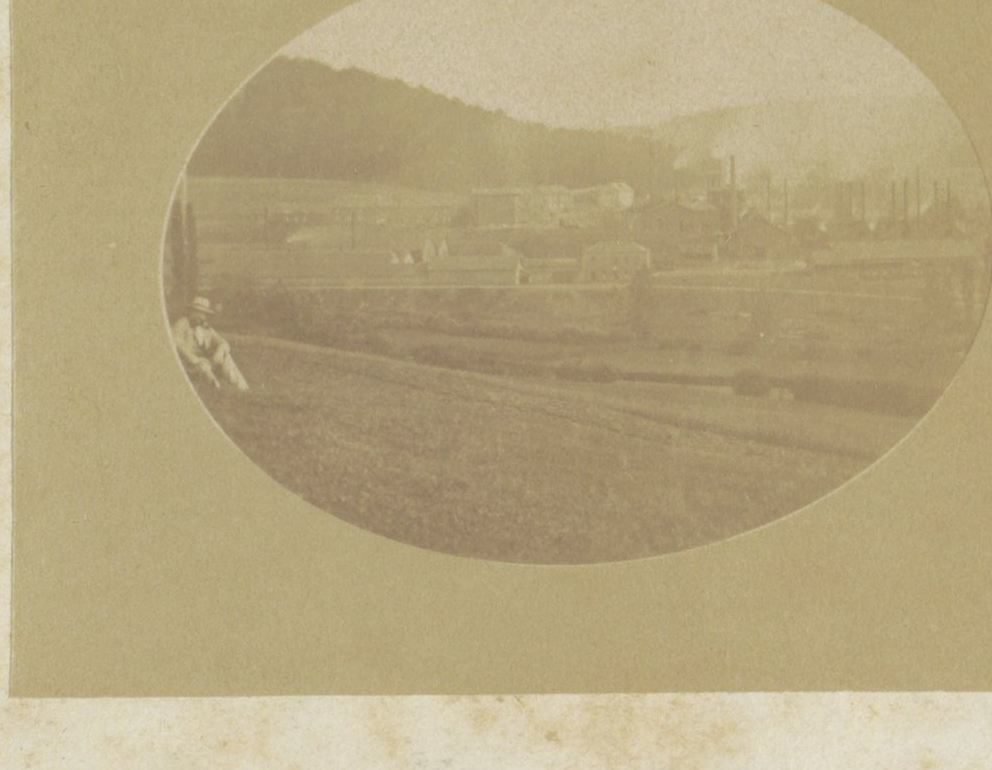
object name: photograph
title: Gezicht op een fabriekscomplex met rokende schoorstenen, vermoedelijk in Frankrijk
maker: Anonymous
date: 1883-1886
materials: photographic support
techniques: albumen print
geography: france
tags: factory-building, france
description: Onderdeel van Album van een Franse amateurfotograaf met opnames van familie, militairen, industrie, landschappen en bezienswaardigheden in Frankrijk.